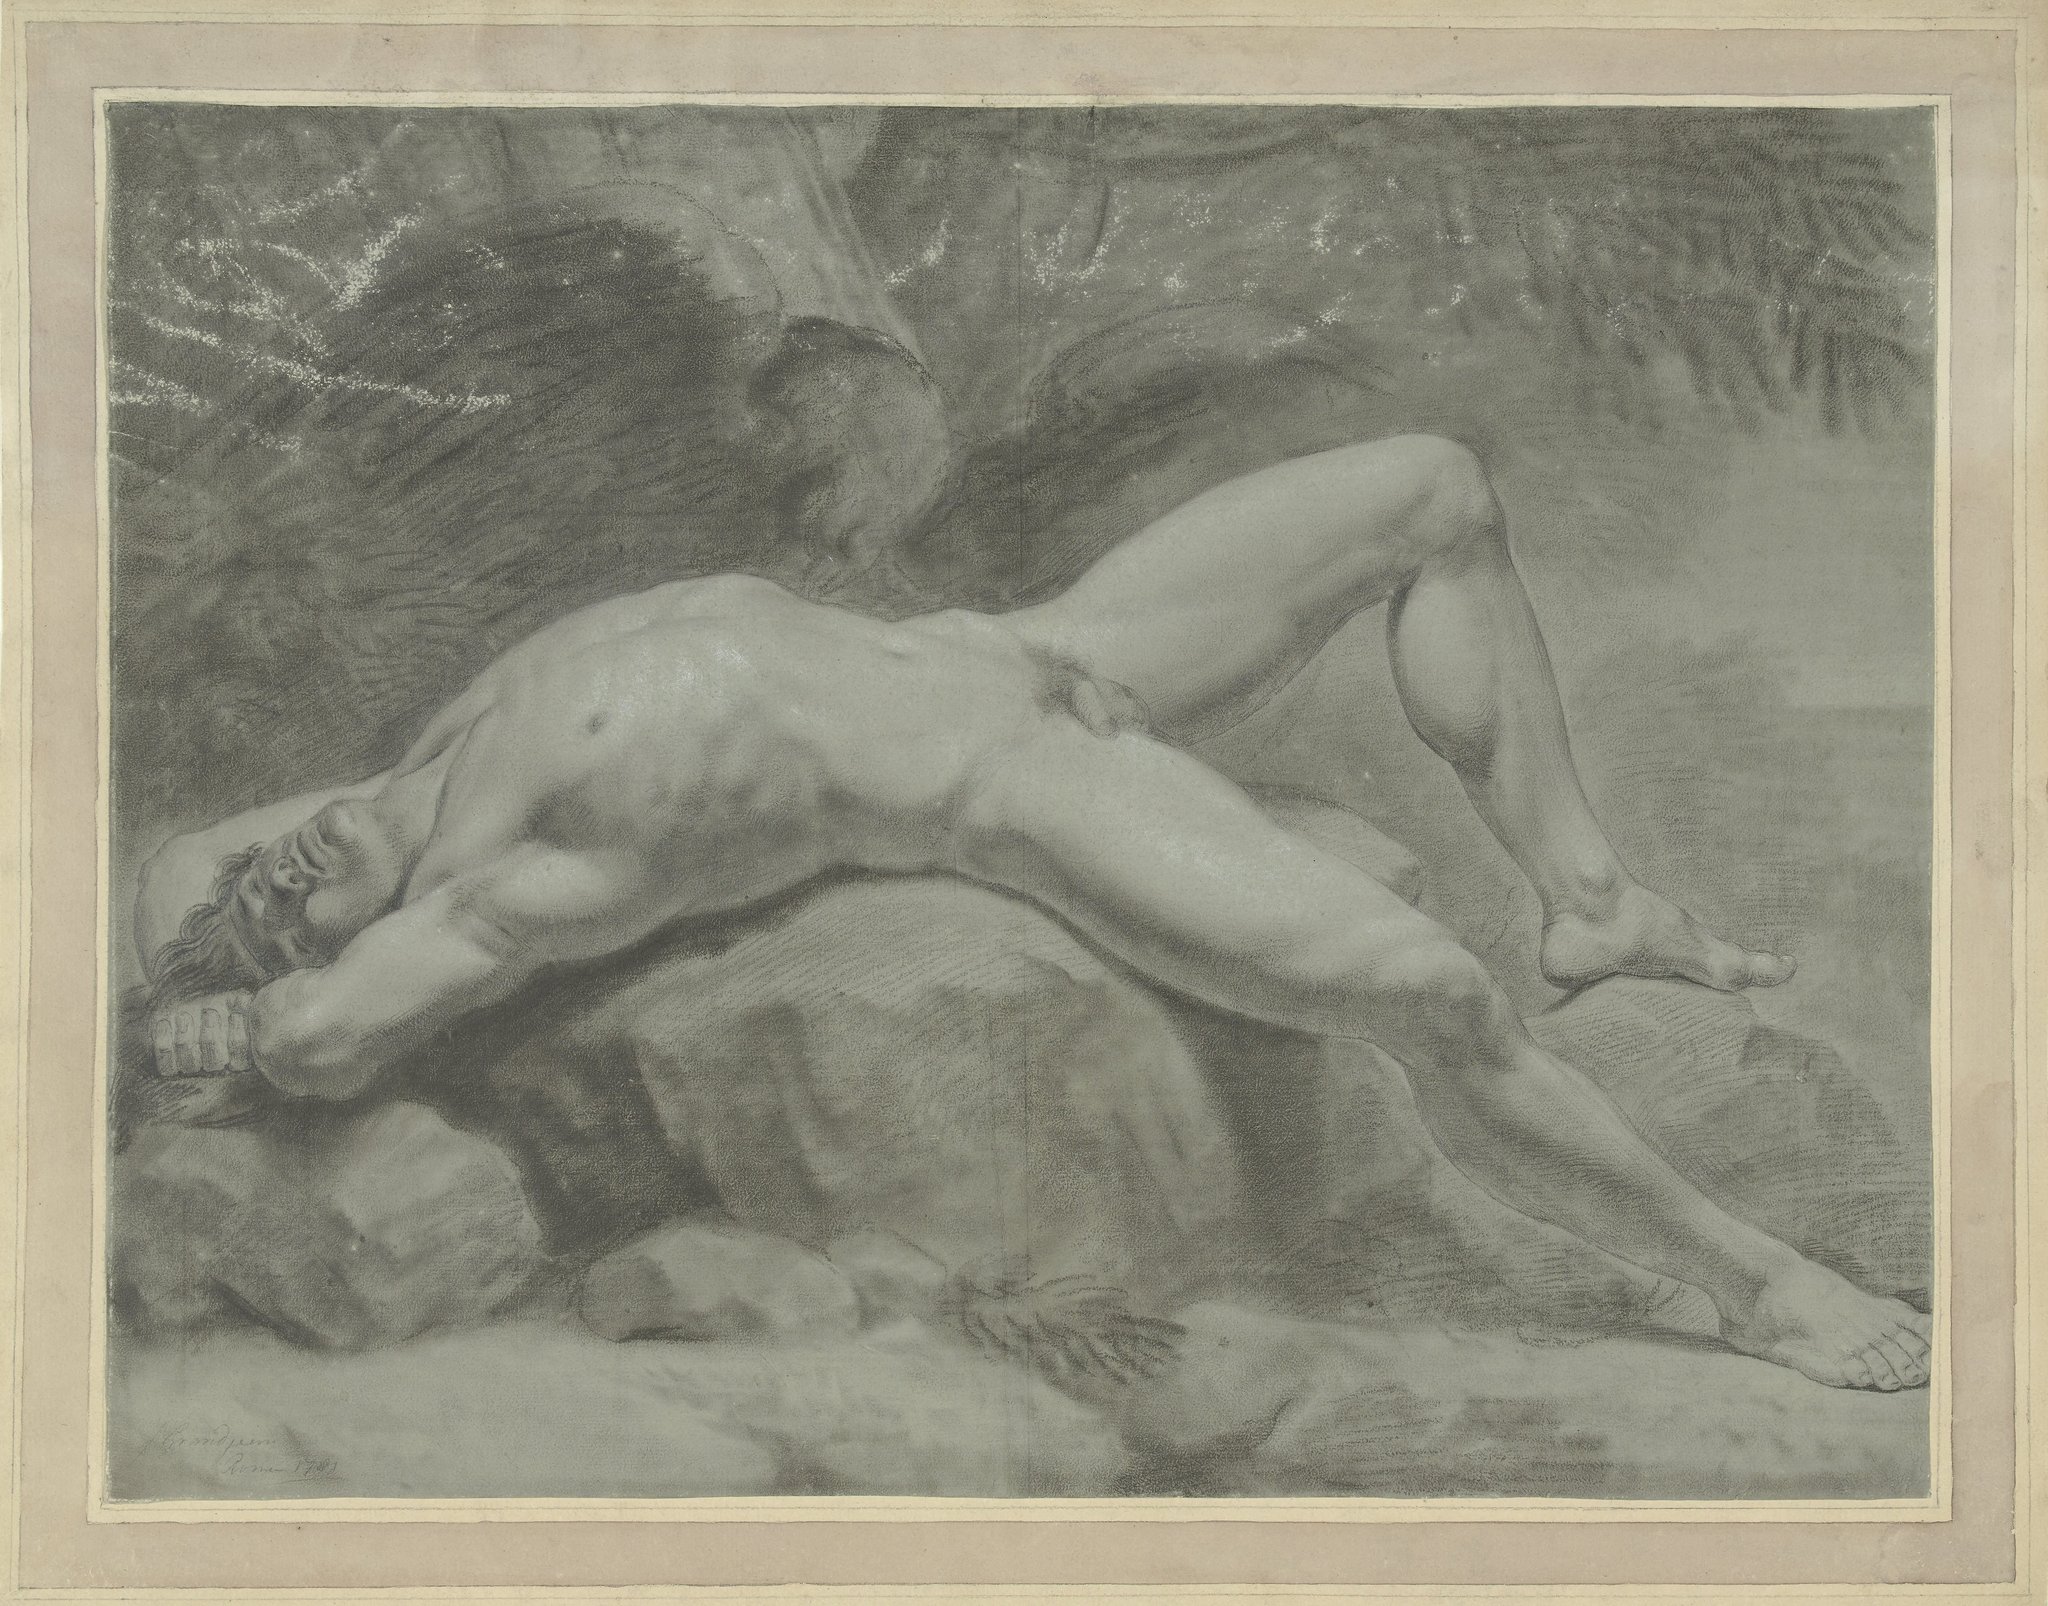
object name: drawing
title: Studie voor Prometheus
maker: jean grandjean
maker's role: draughtsman, print maker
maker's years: 1752-1781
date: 1781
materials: chalk, paper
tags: an eagle tears at prometheus' liver